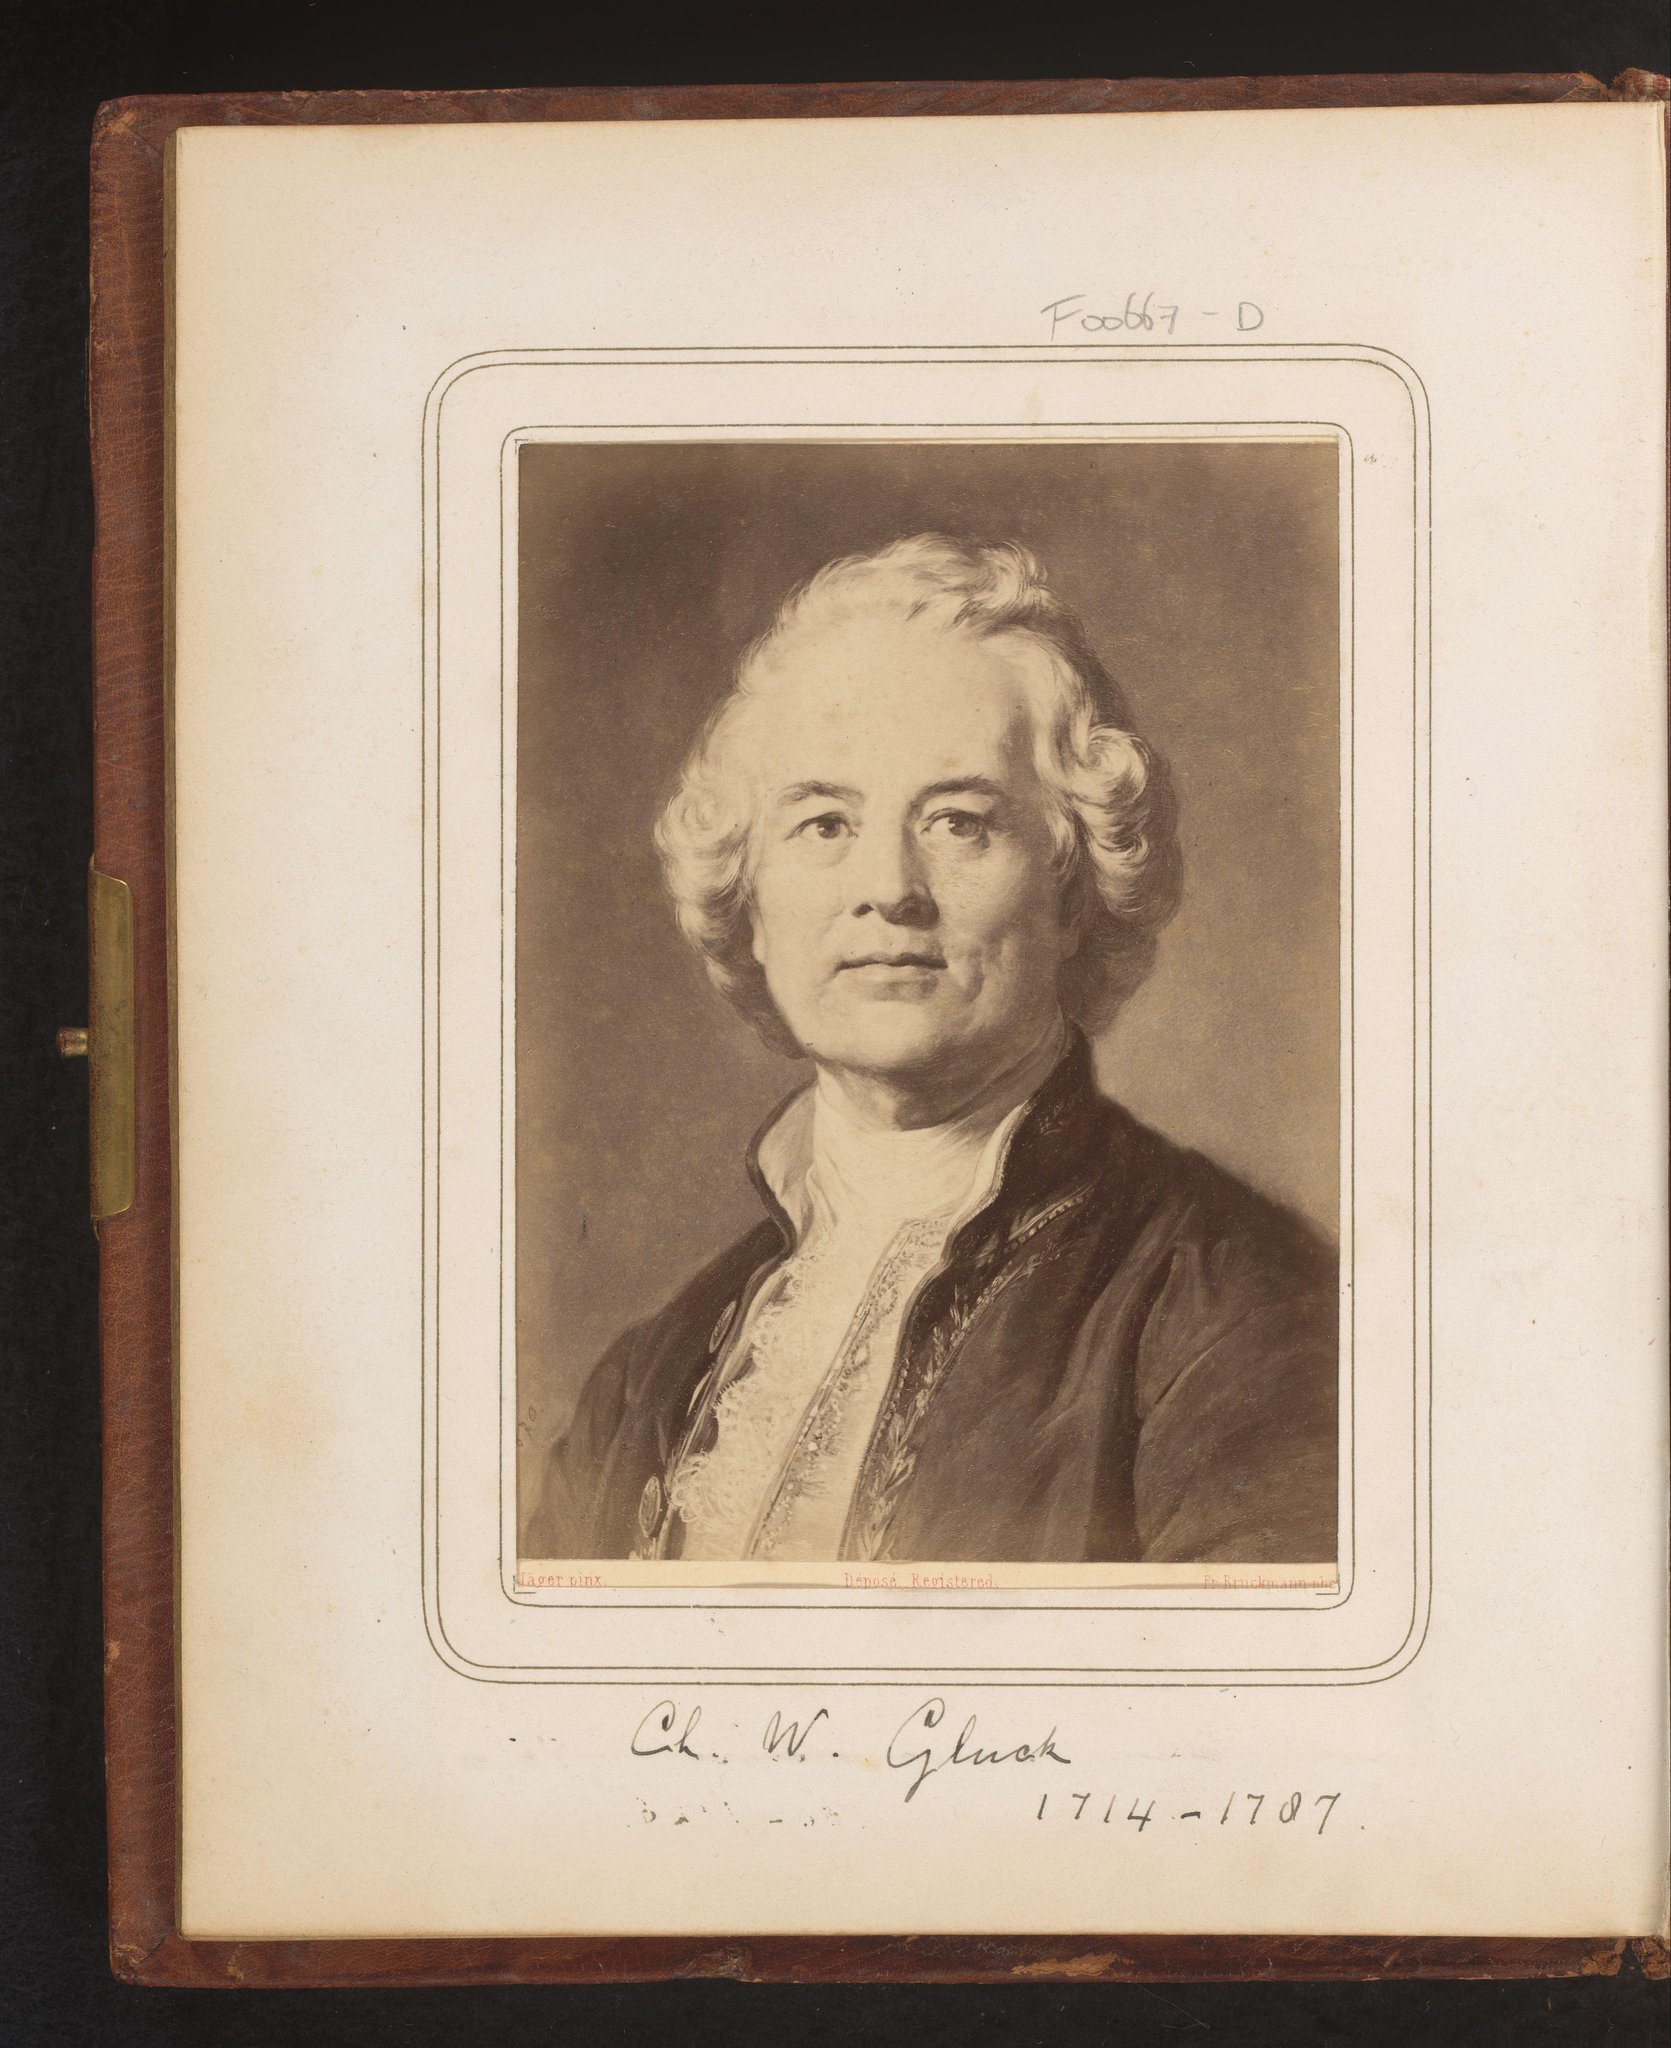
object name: cabinet photograph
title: Fotoreproductie van een geschilderd portret van Christoph Willibald von Gluck door Carl Jaeger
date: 1870-1890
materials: cardboard, photographic support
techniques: albumen print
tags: vienna, christoph willibald von gluck, historical persons, portrait of composer, picture, painting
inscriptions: annotation: ‘Ch. W. Gluck/ 1714 - 1787’, name: ‘Jäger pinx. Déposé Registered/ Fr. Bruckmann pho[...]’